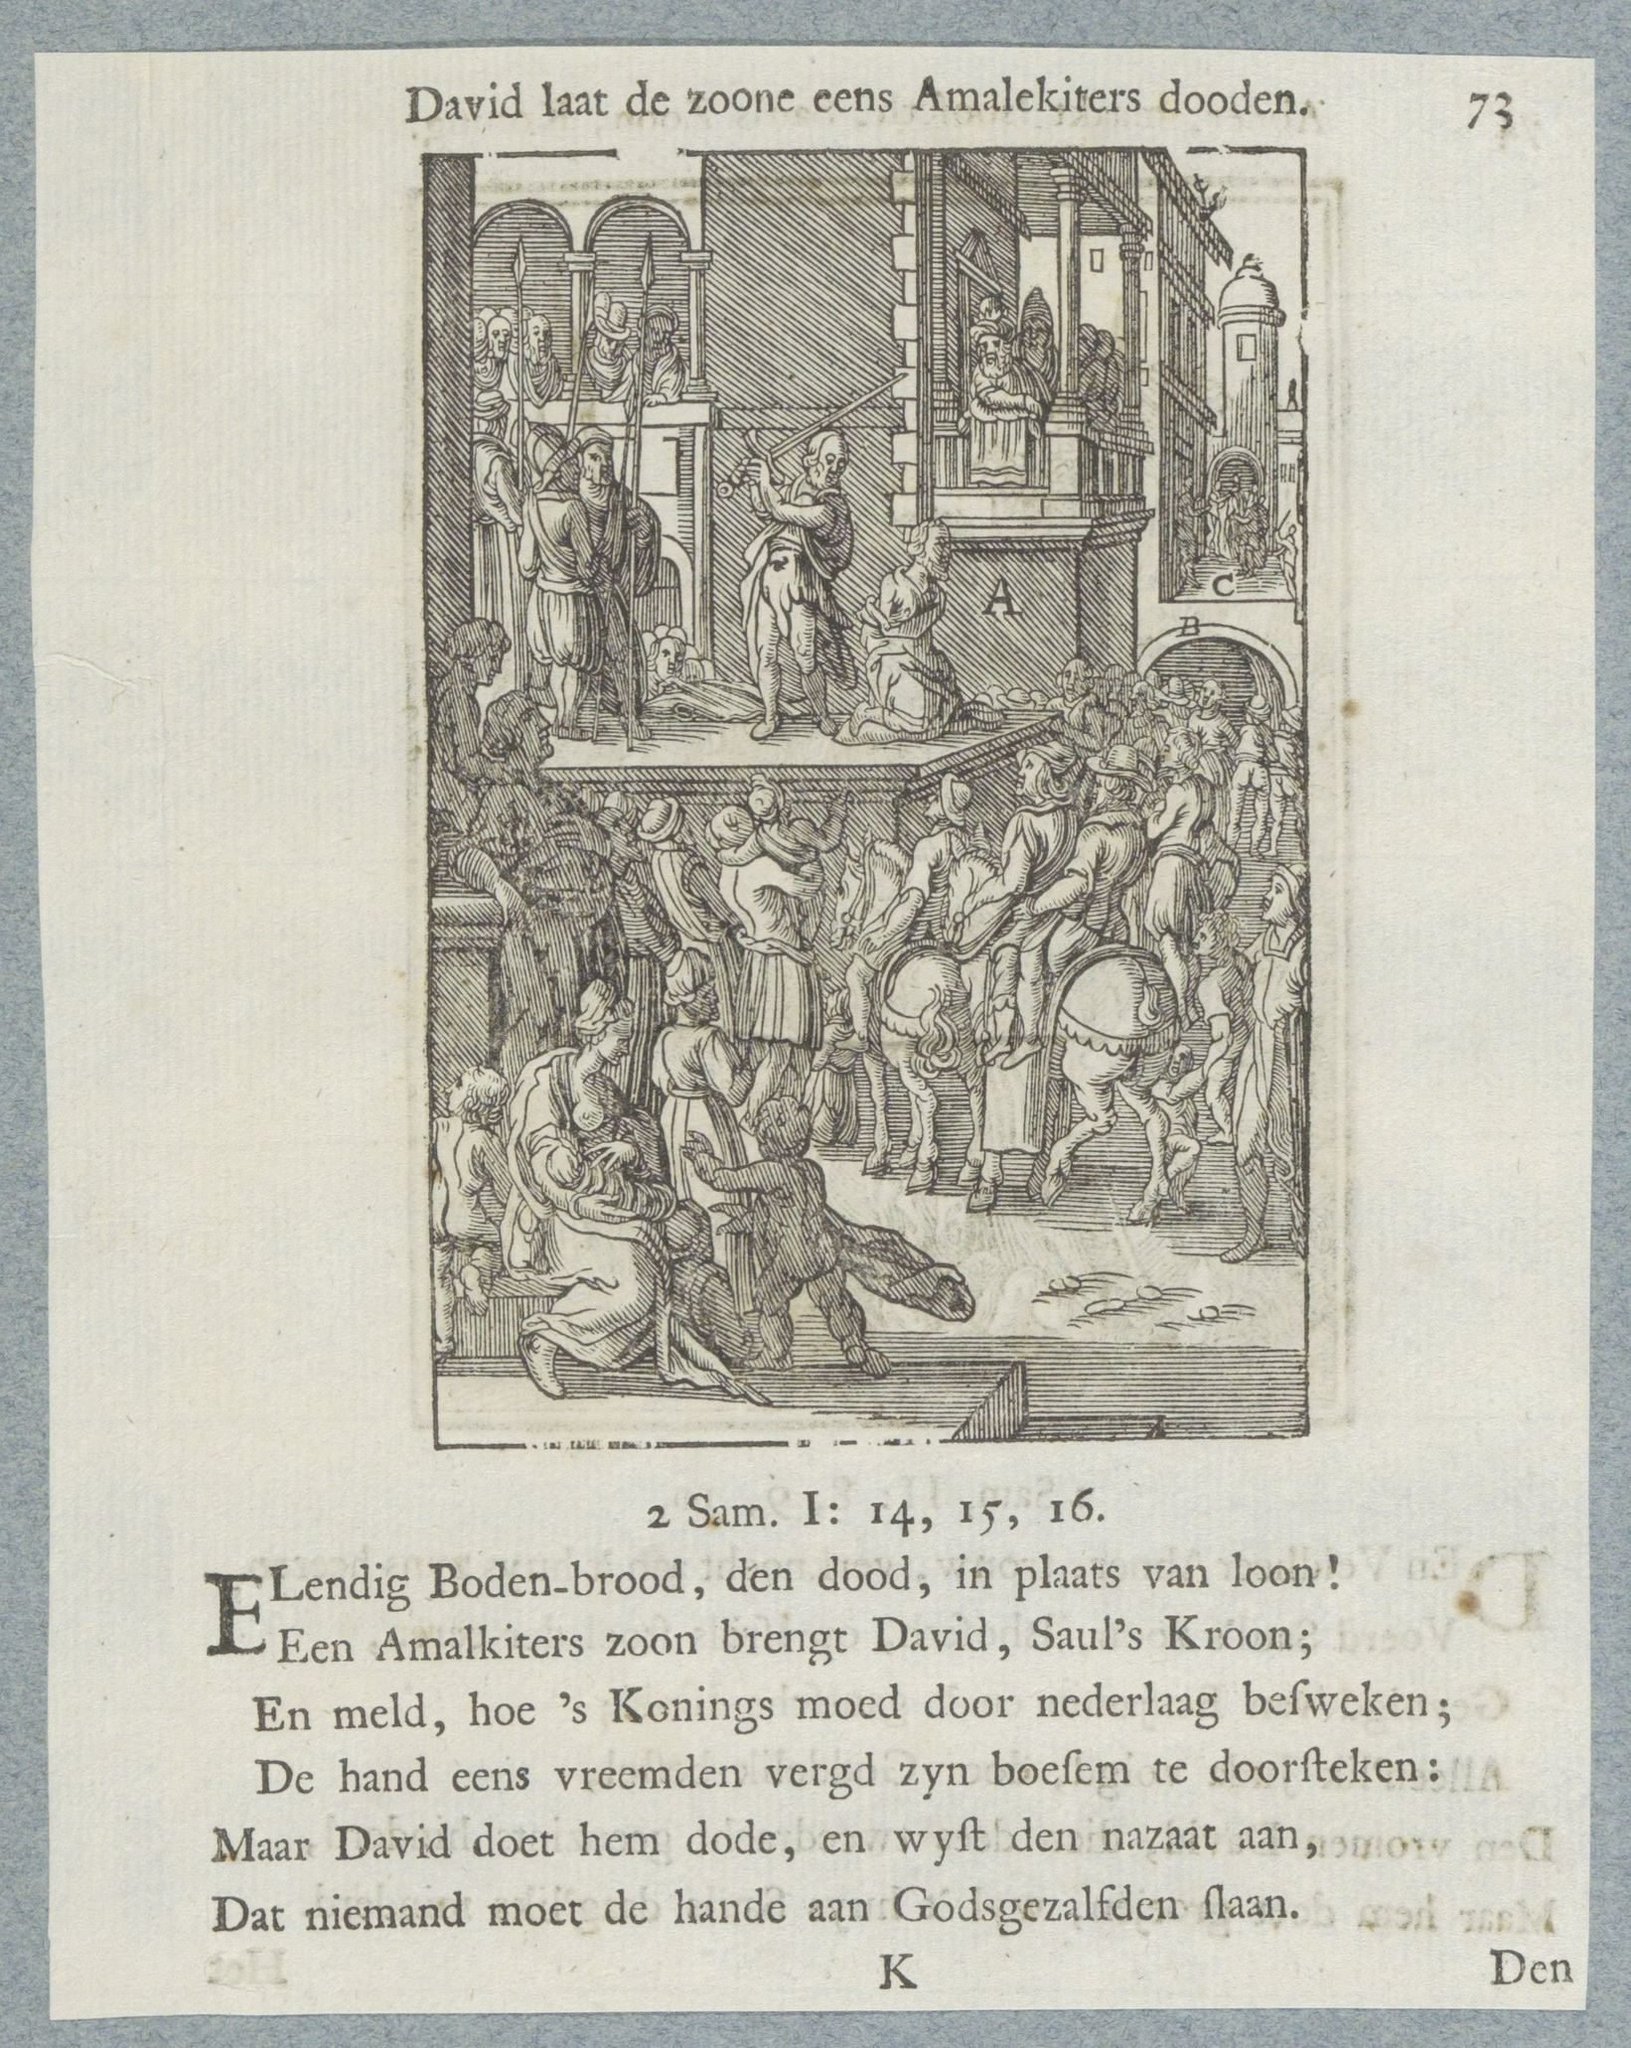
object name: album leaf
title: David laat de Amalkiet doden die Saul de genadestoot gaf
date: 1629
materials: paper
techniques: letterpress printing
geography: amsterdam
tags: beheading of james, the messenger who brought david the message of saul's death is put to death by one of david's soldiers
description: De prent is afkomstig uit: Bybels Lusthof. Amsterdam, J. Klooster, 1740. Ze werd voor het eerst gebruikt als afbeelding van de onthoofding van Jakobus de Meerdere in: Der Zielen Lust-hof. Leuven, I.Jacbosz voor P.J. Paets [= Amsterdam, P.J. Paets], 1629. De voorstelling is gekopieerd naar een prent van Philips Galle naar Jan van der Straet.